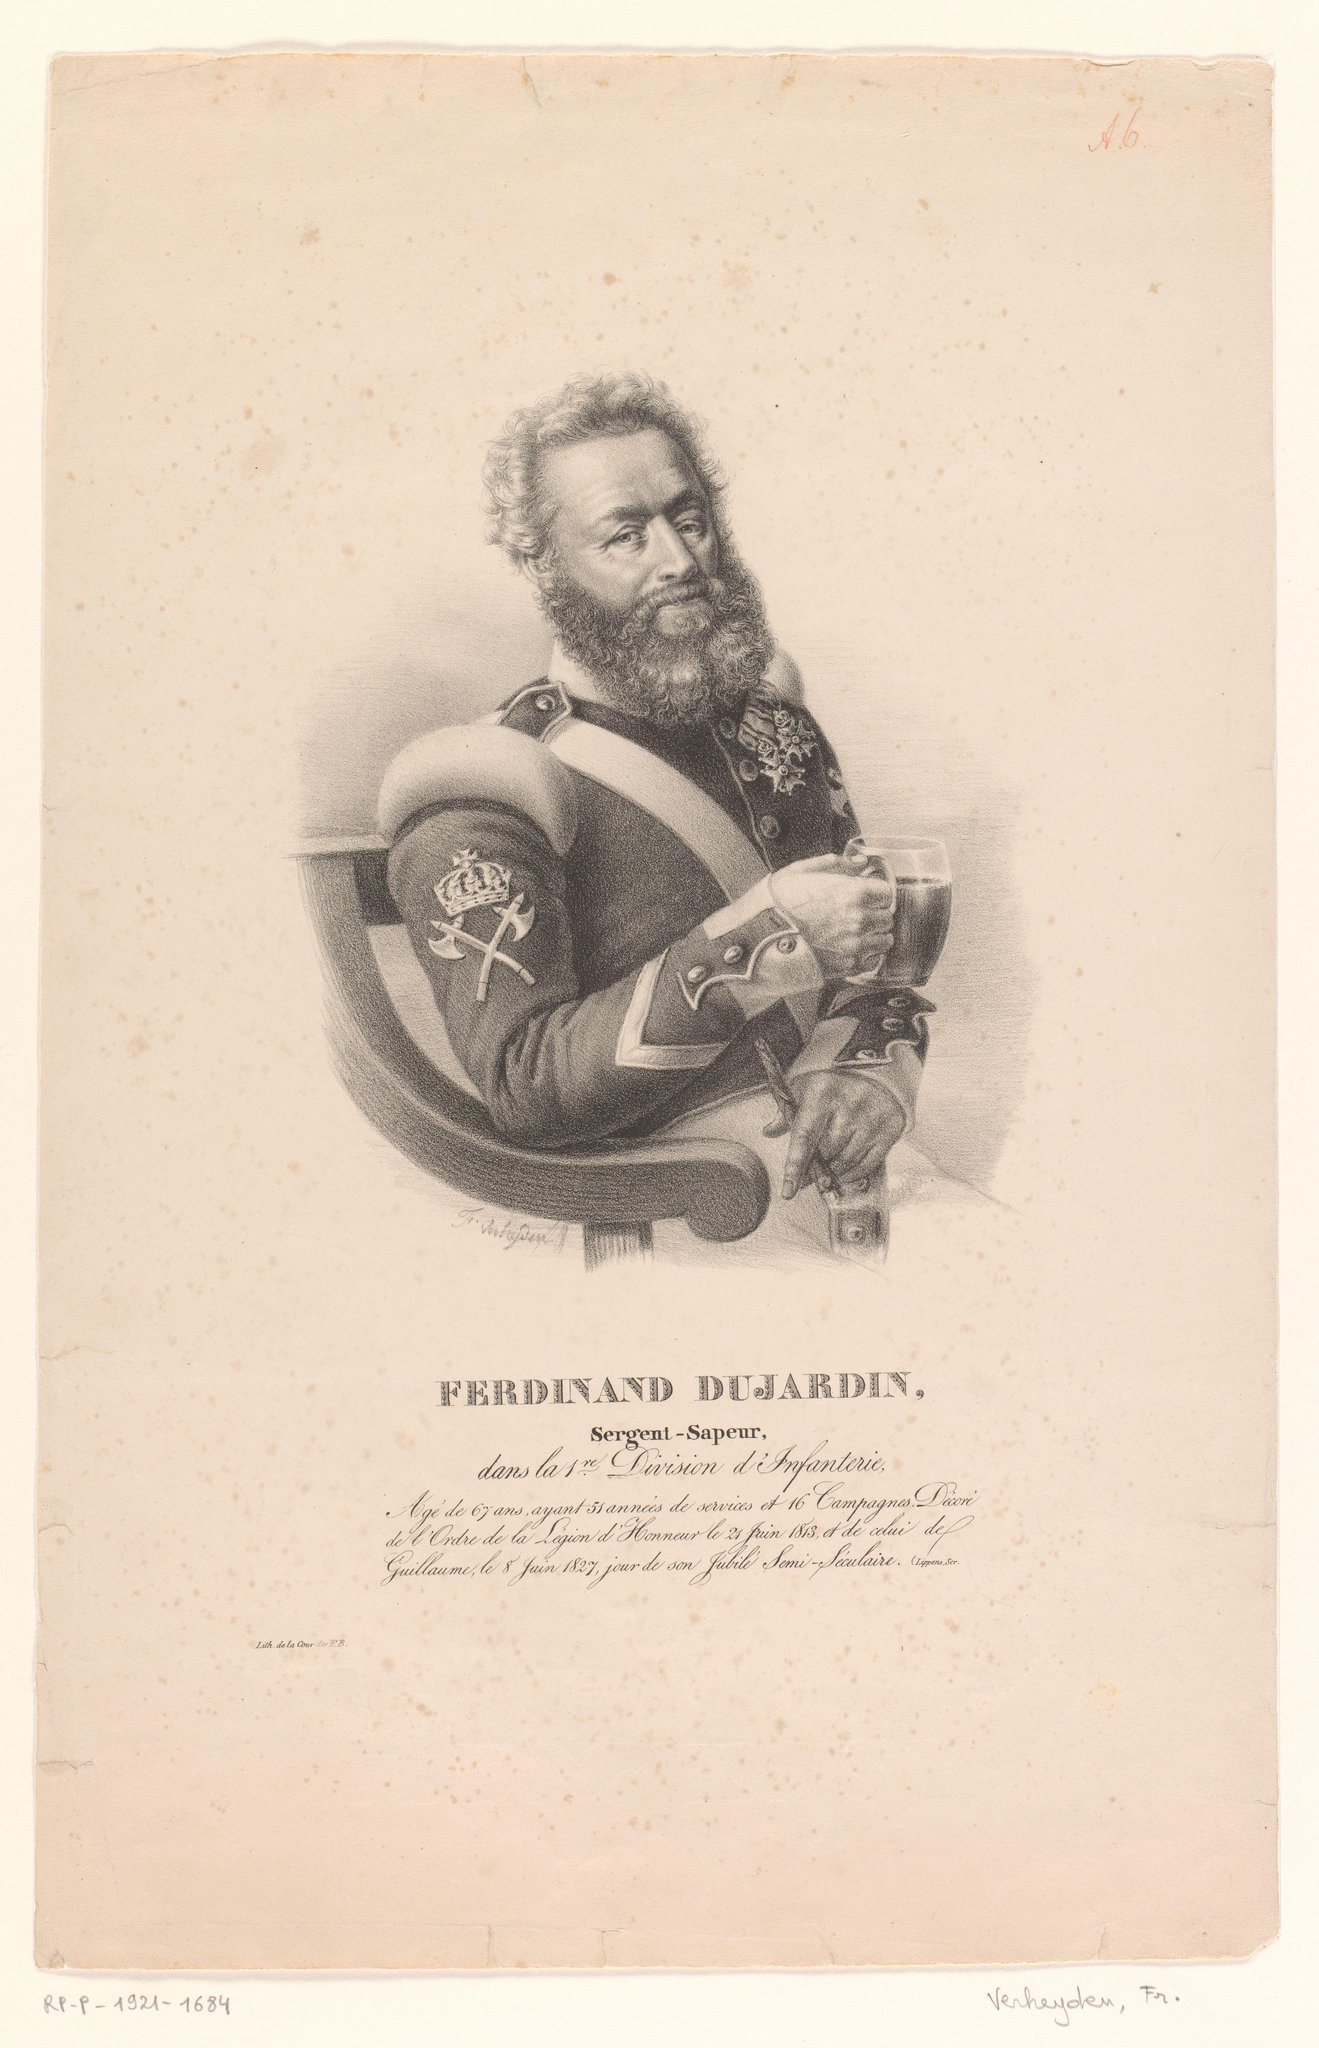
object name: print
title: Ferdinand Dujardin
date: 1827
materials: paper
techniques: lithograph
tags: ranks in the army, historical persons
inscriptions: collector's mark: Lugt 2233